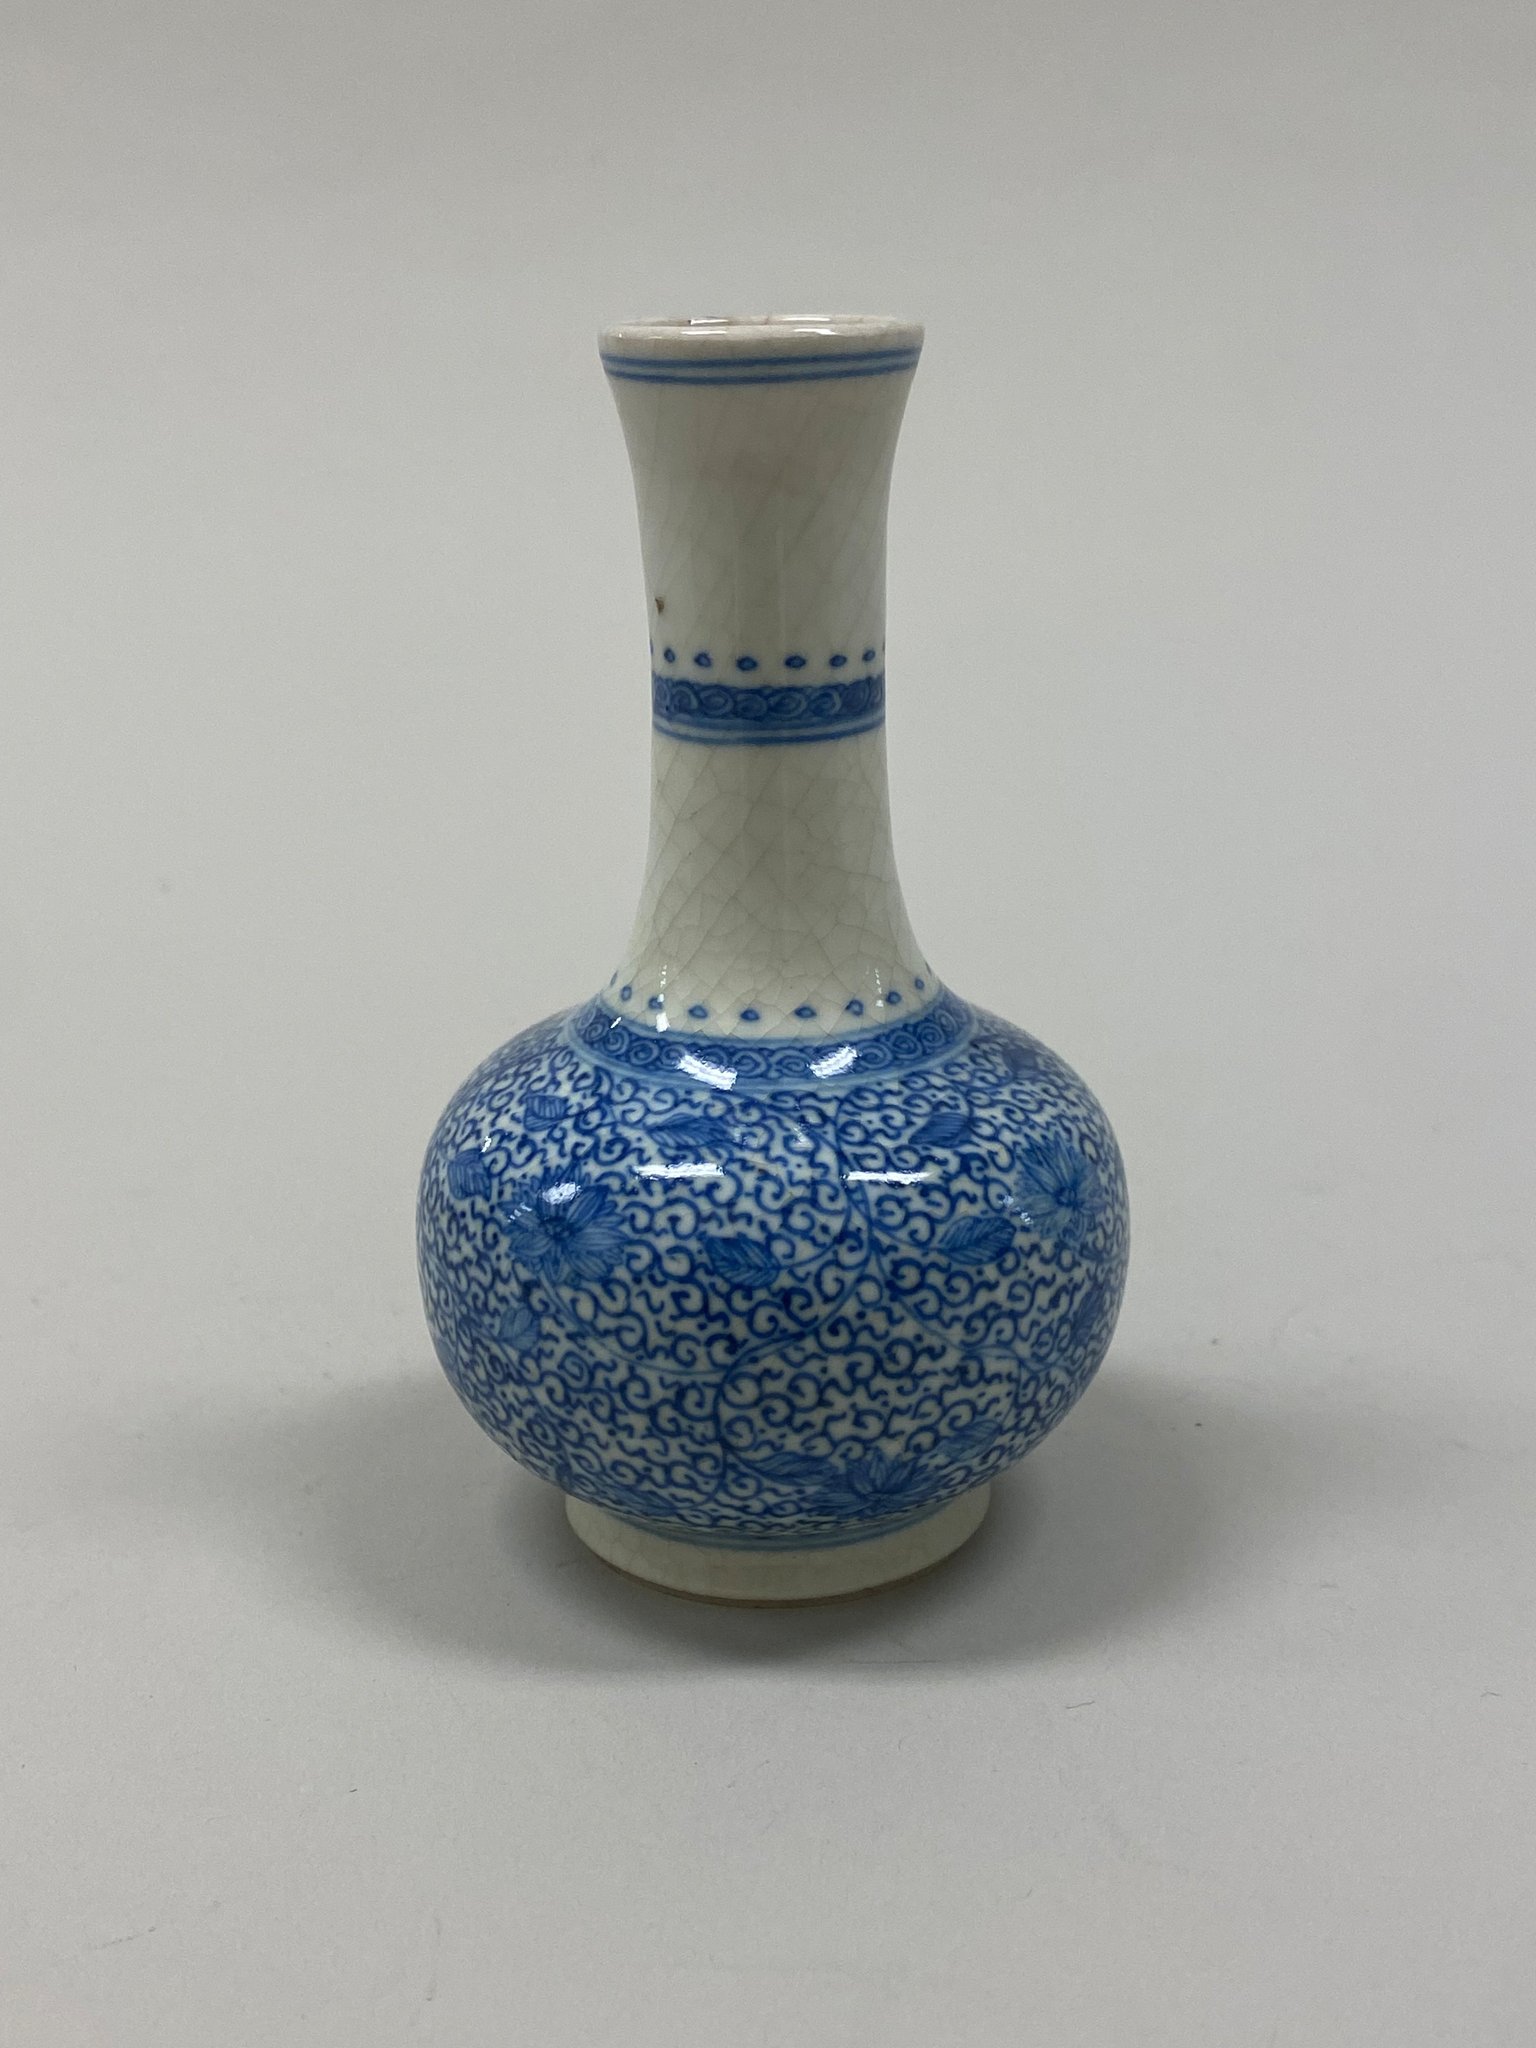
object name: vase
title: Vase with floral scrolls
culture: chinese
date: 1667-1733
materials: cobalt, soft paste porcelain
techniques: painting, underglaze